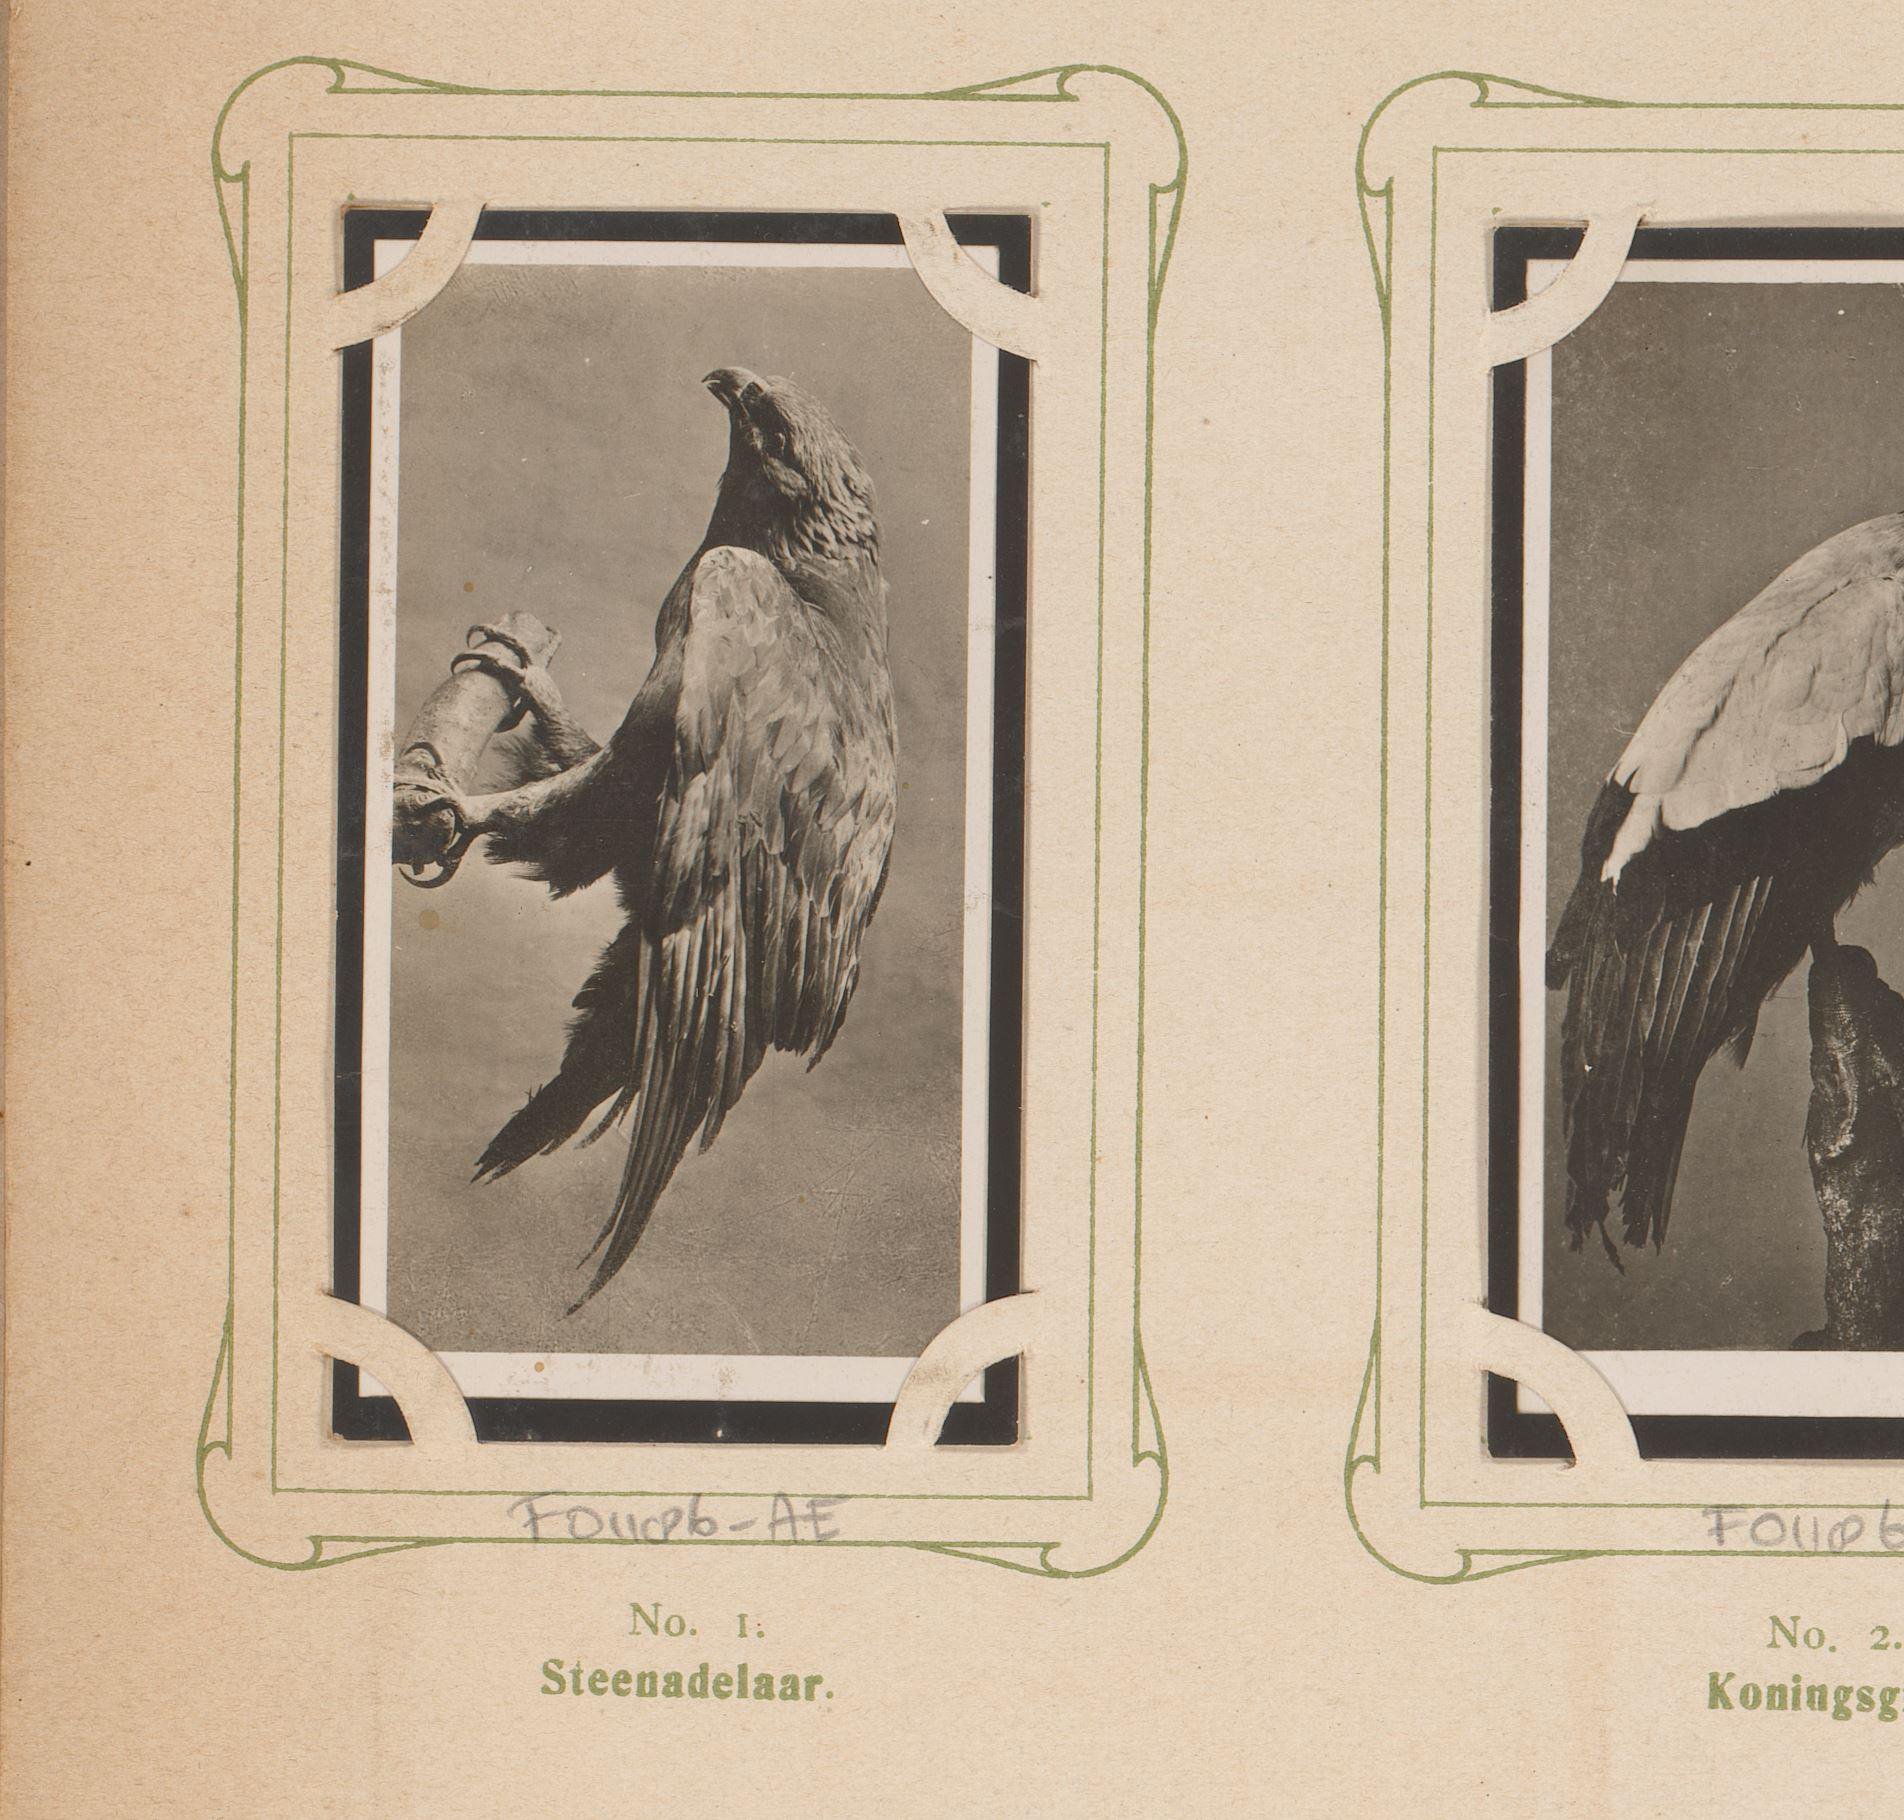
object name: album leaf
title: Steenadelaar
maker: Anonymous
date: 1904-1905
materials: photographic support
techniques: gelatin silver print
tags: predatory birds: eagle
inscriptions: inscription: ‘No. 1./ Steenadelaar.’